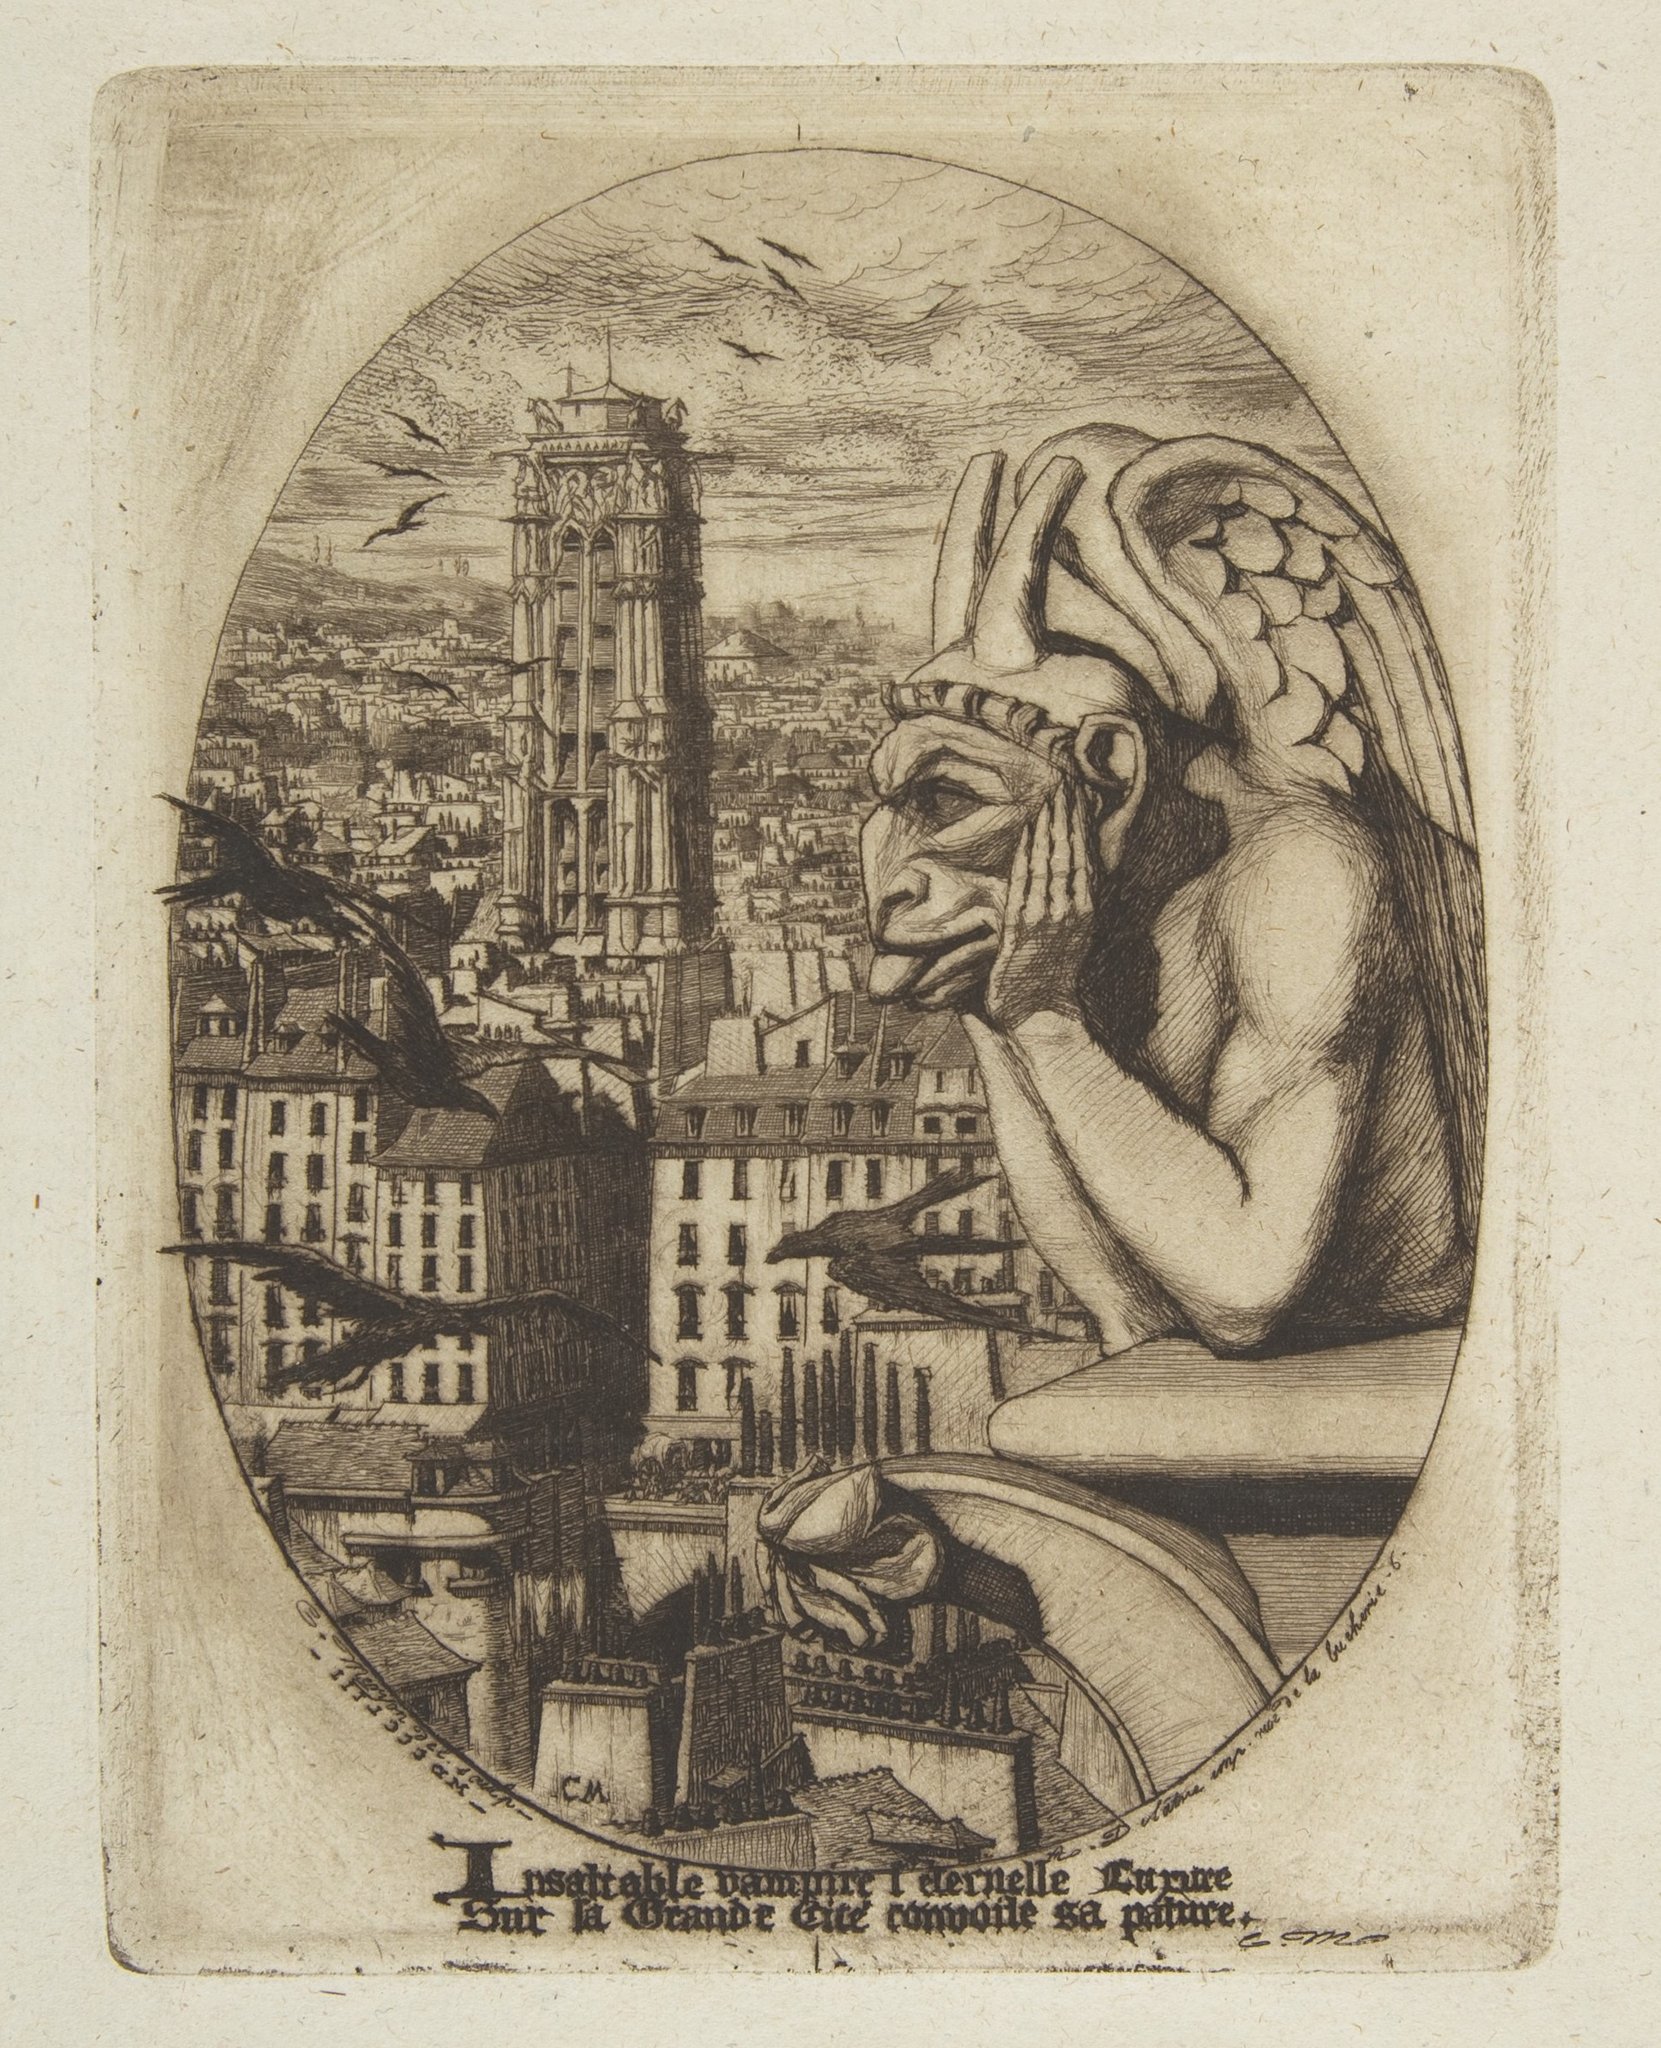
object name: print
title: The Vampire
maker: charles meryon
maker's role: artist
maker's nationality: french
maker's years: 1821-1868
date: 1853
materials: ink, paper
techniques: etching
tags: birds,buildings,cities,paris